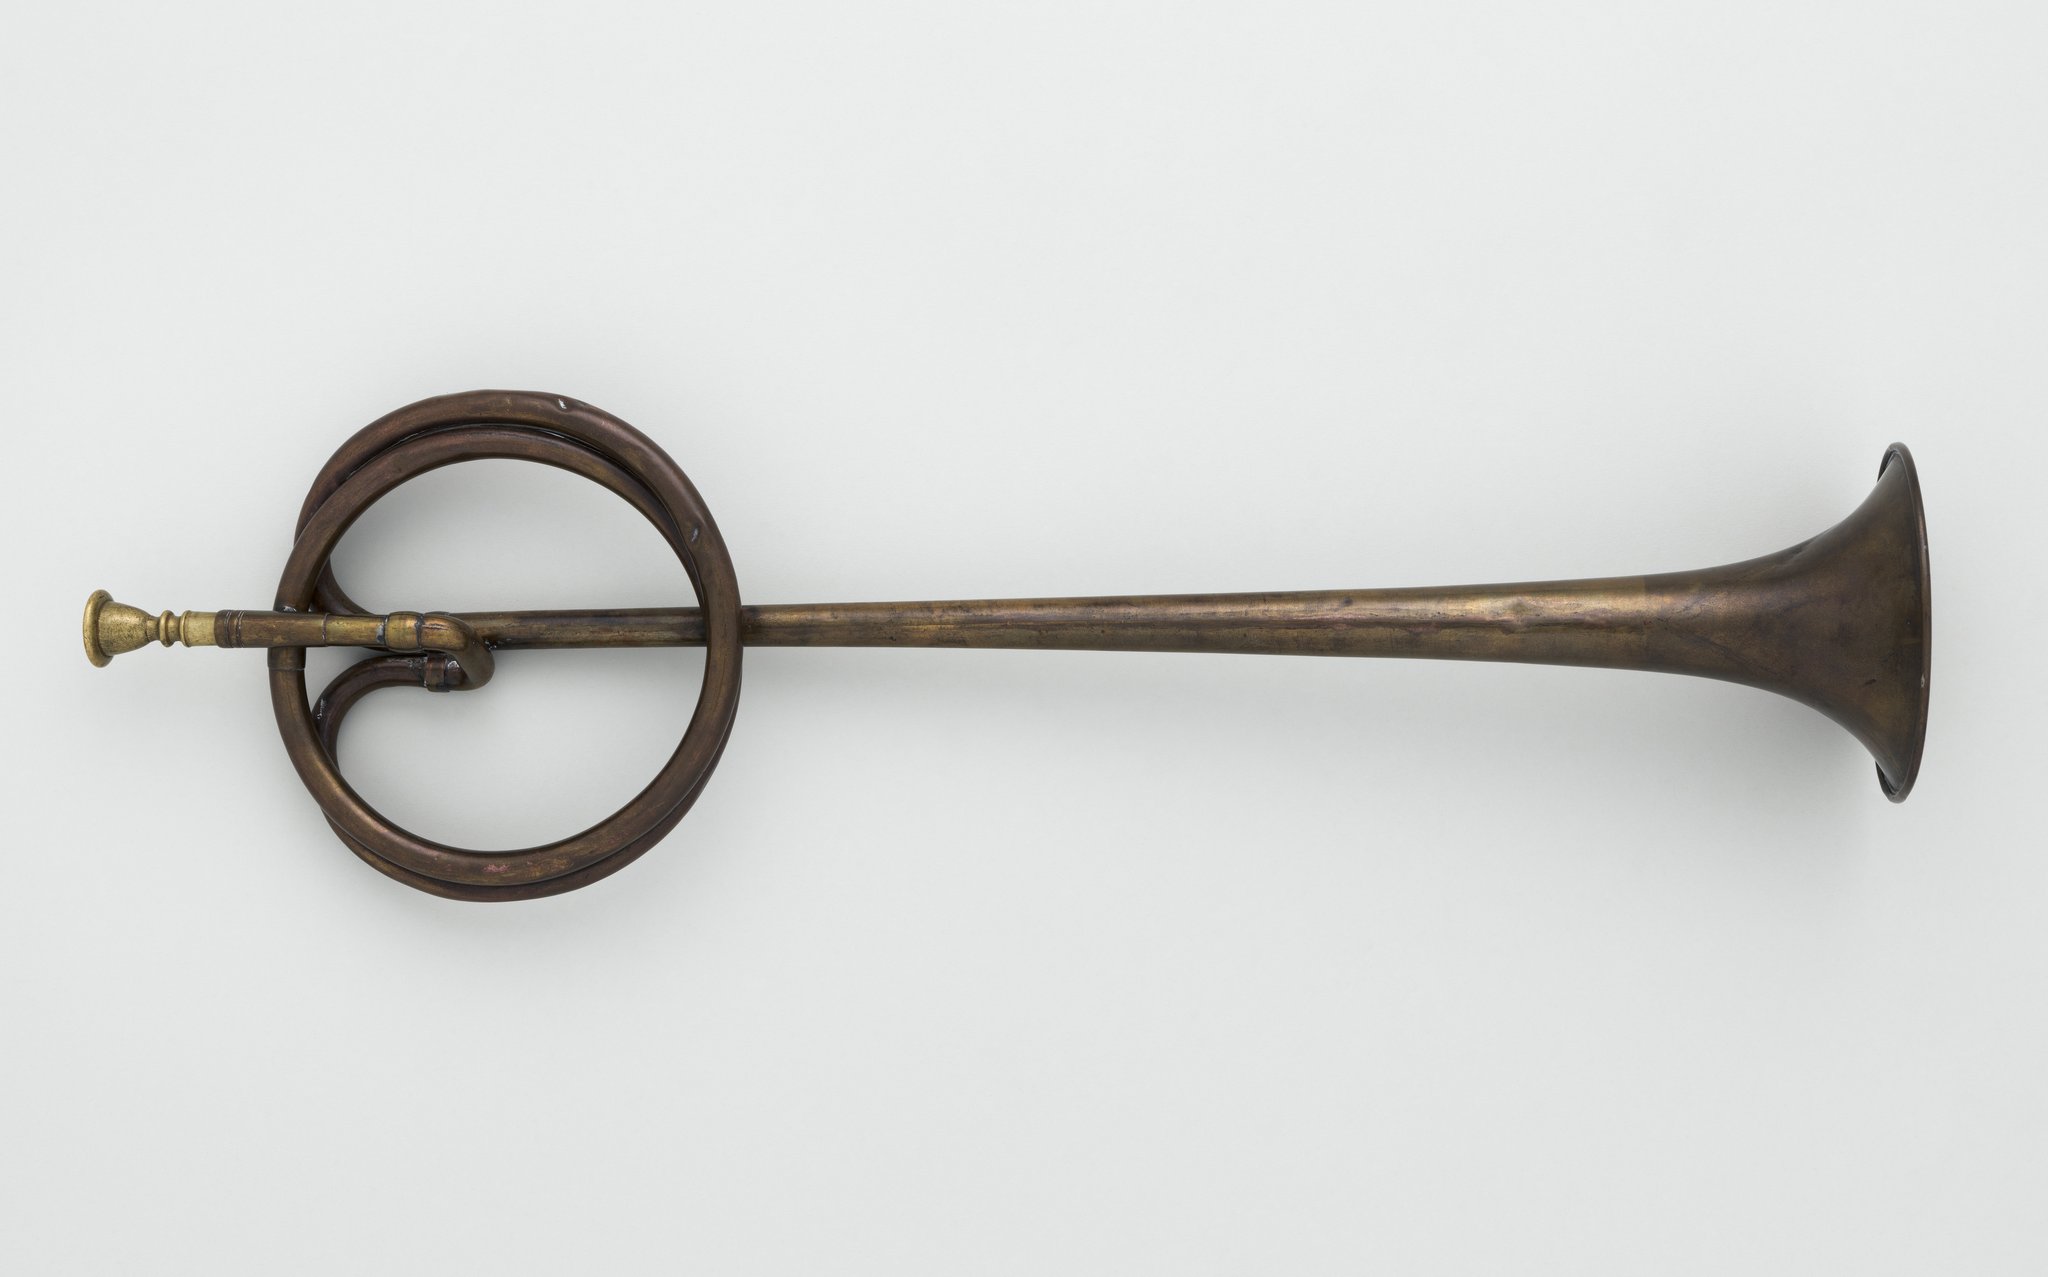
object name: natural trumpet in d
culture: french or italian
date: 1867-1900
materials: brass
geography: italy